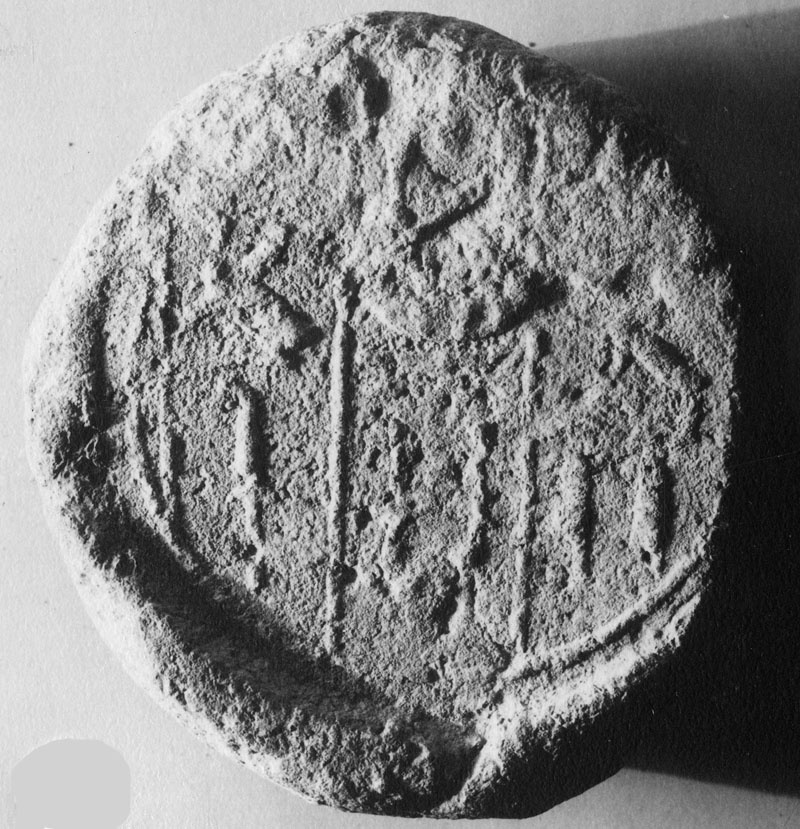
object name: cone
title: Funerary Cone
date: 1550-1295 BCE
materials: pottery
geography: egypt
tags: hieroglyphs